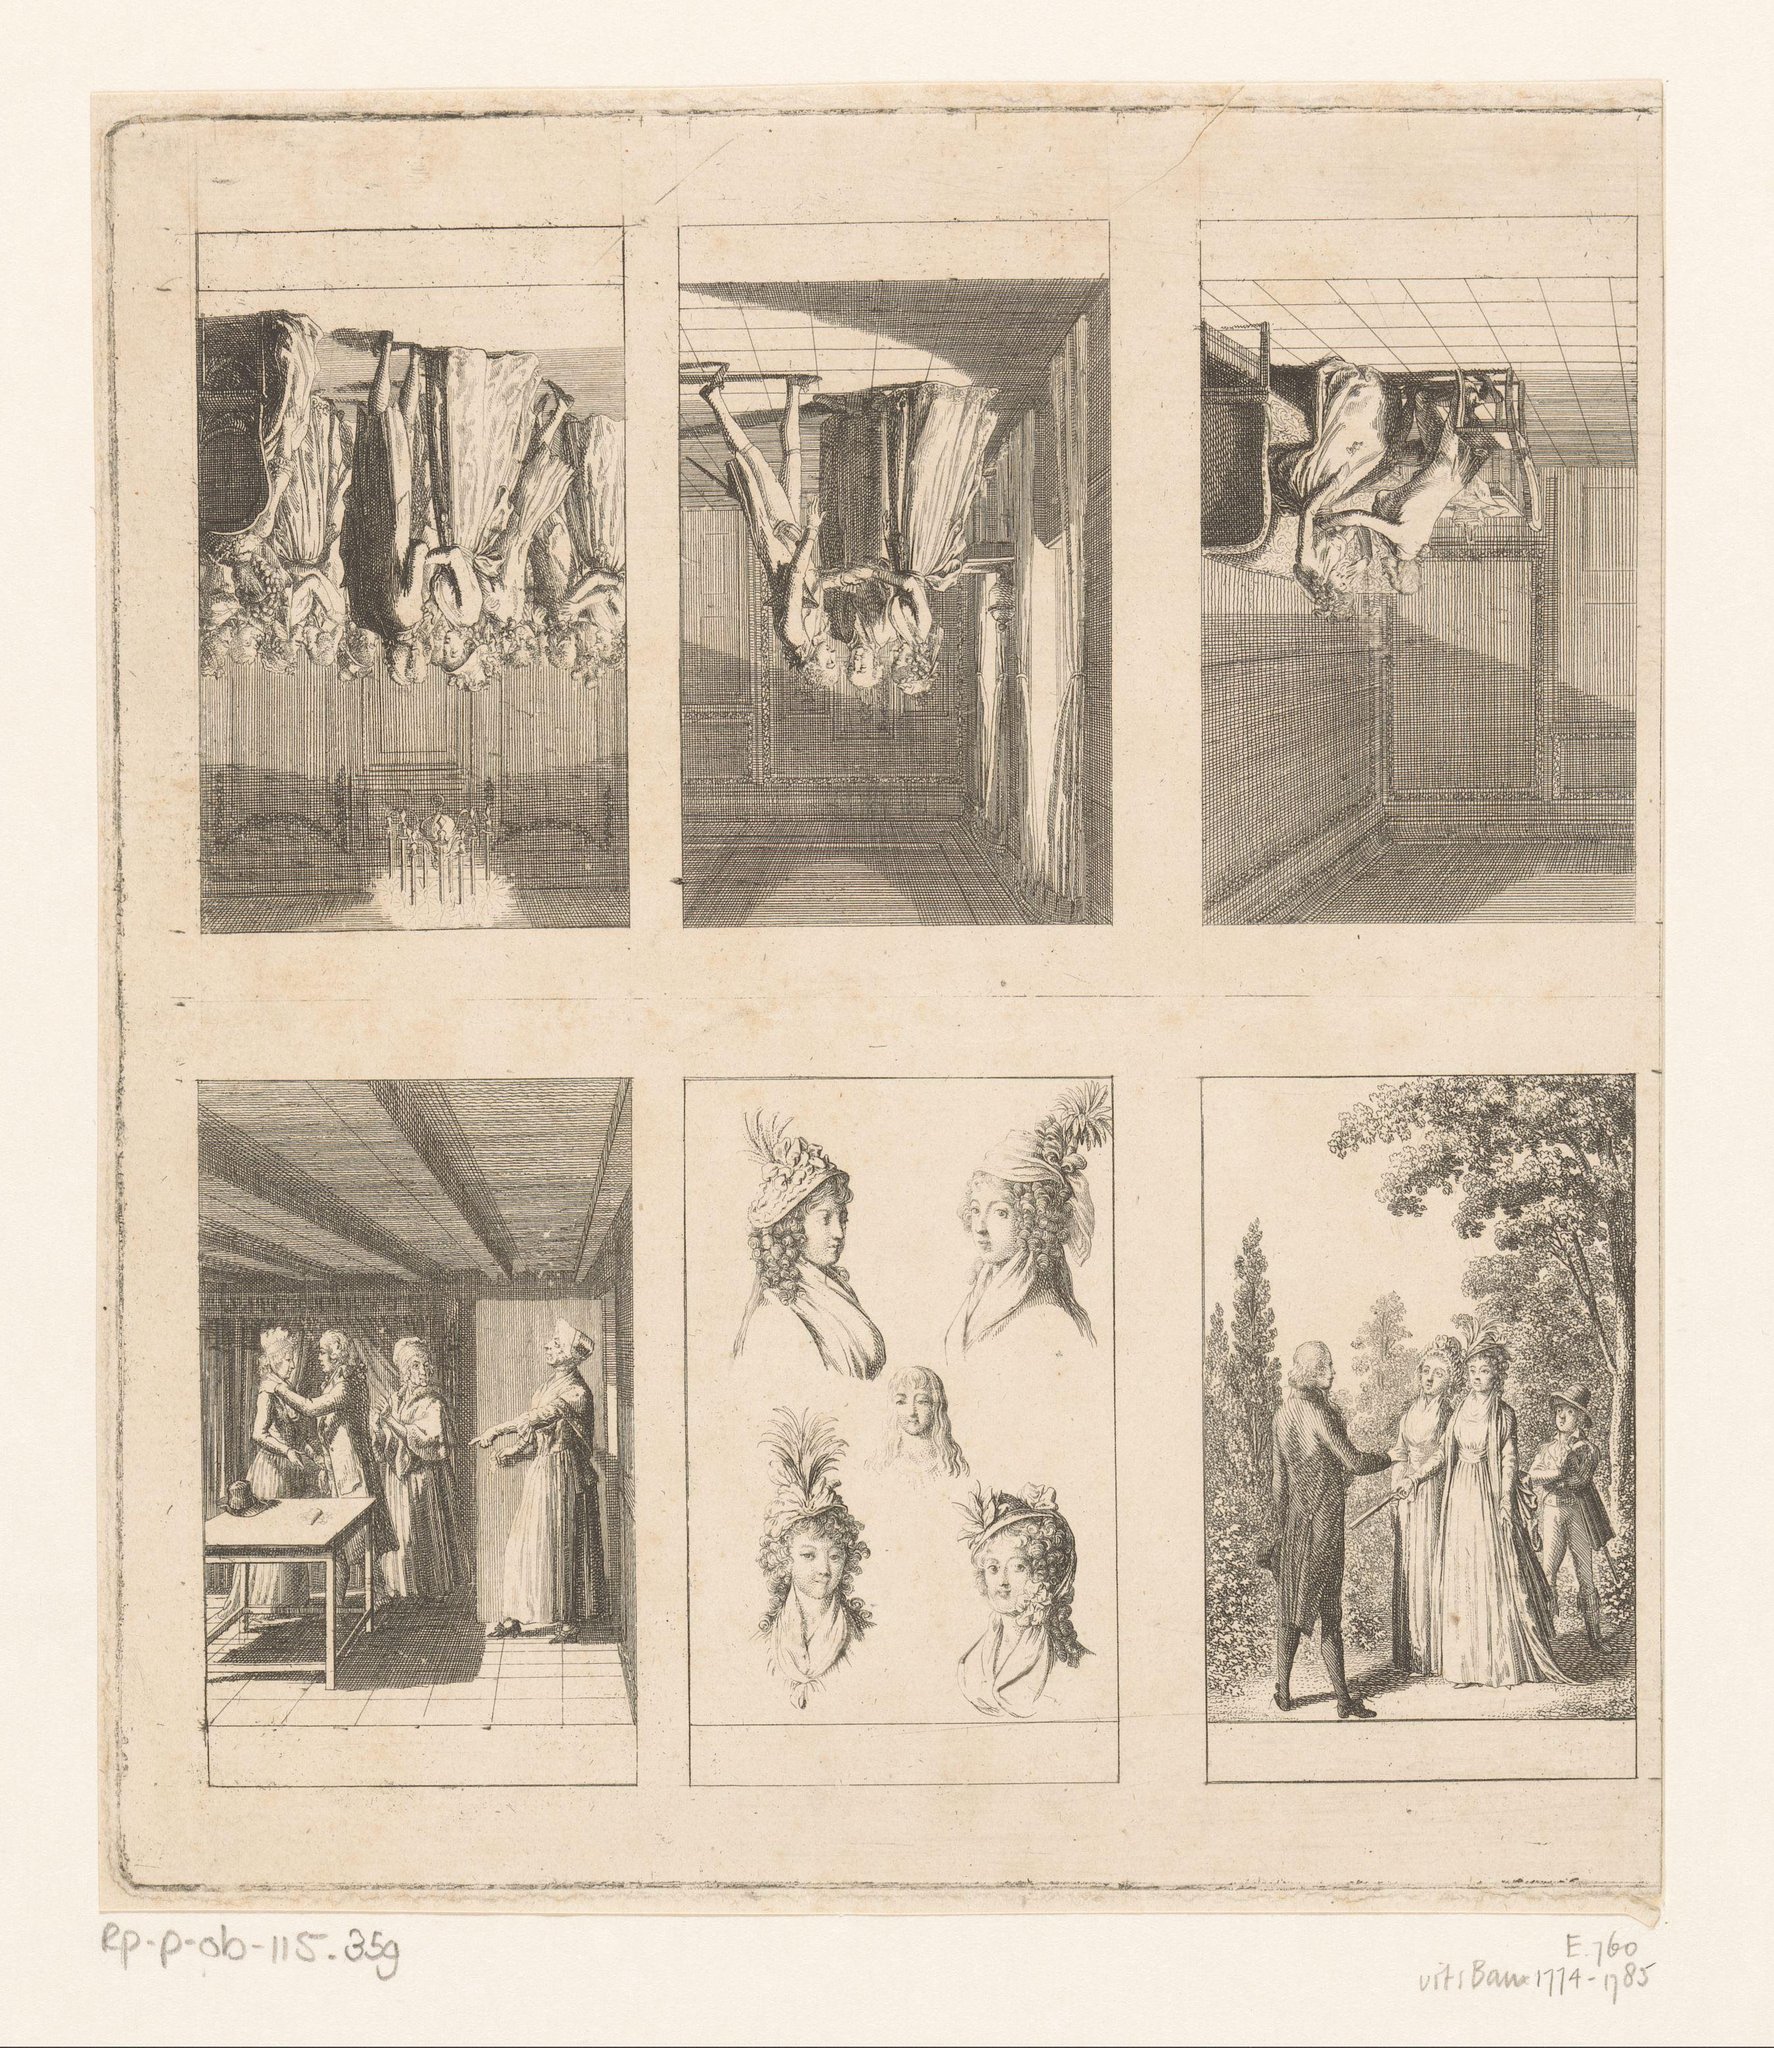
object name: print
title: Zes voorstellingen uit de huwelijksgeschiedenis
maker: daniel nikolaus chodowiecki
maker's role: draughtsman, print maker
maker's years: 1726-1801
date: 1795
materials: paper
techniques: etching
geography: berlin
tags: betrothal and marriage, fashion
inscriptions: collector's mark: Lugt 2228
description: Latere staat gebruikt voor: Kalender für sittliche und angenehme Unterhaltung, auf das Schaltjahr 1796. Berlijn: Johann Friedrich Unger, [1794].